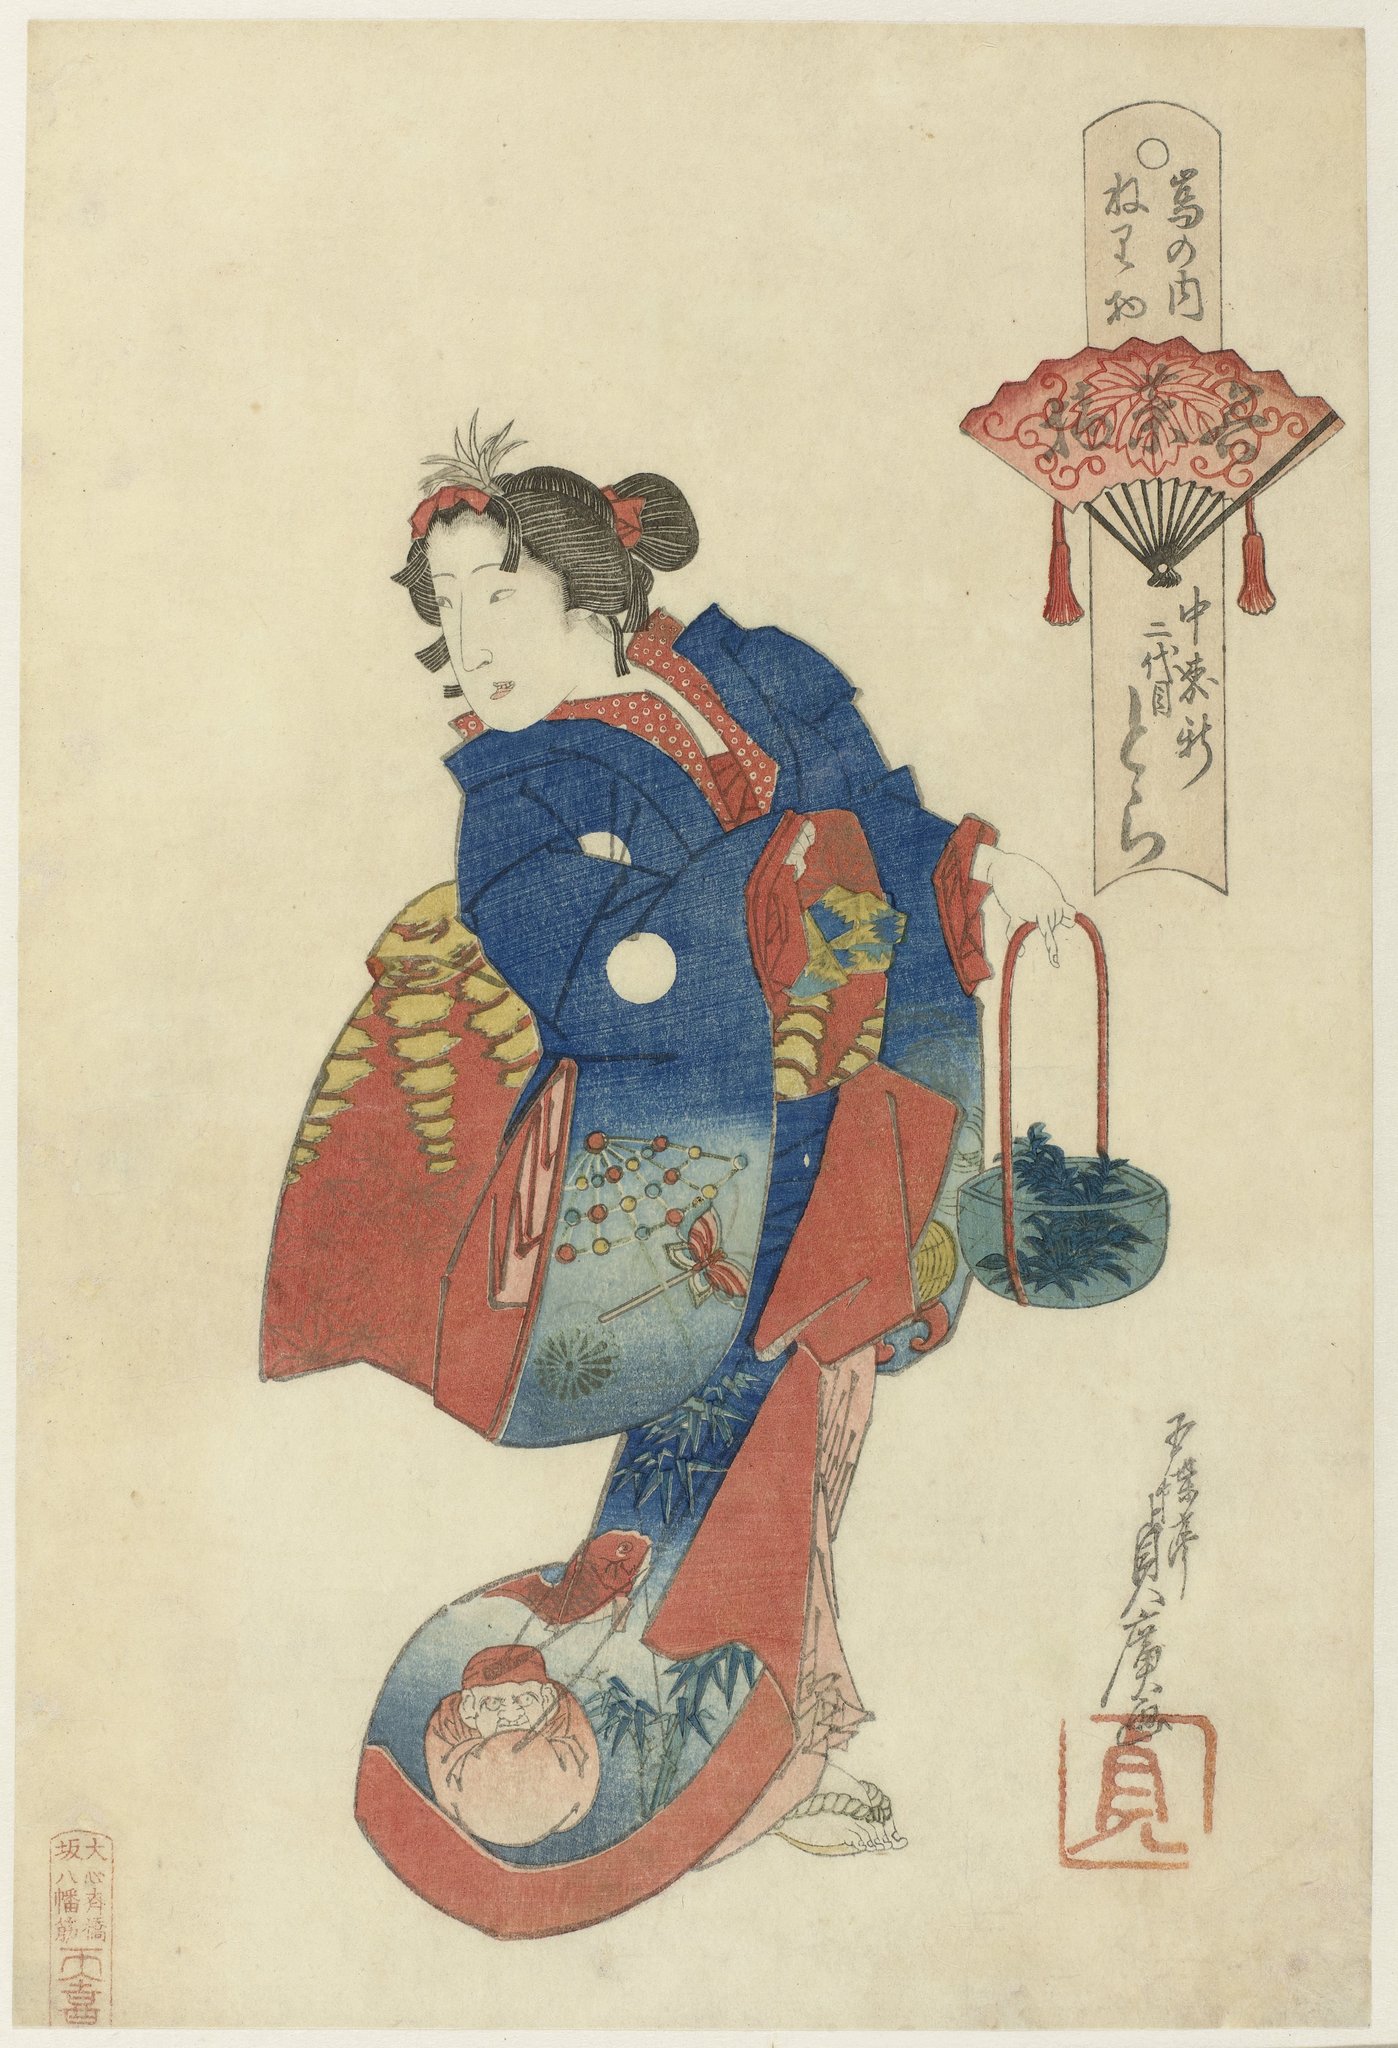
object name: print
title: Shimanouchi nerimono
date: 1836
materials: paper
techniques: woodcut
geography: osaka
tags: weapons, courtesan, hetaera, gathering herbs